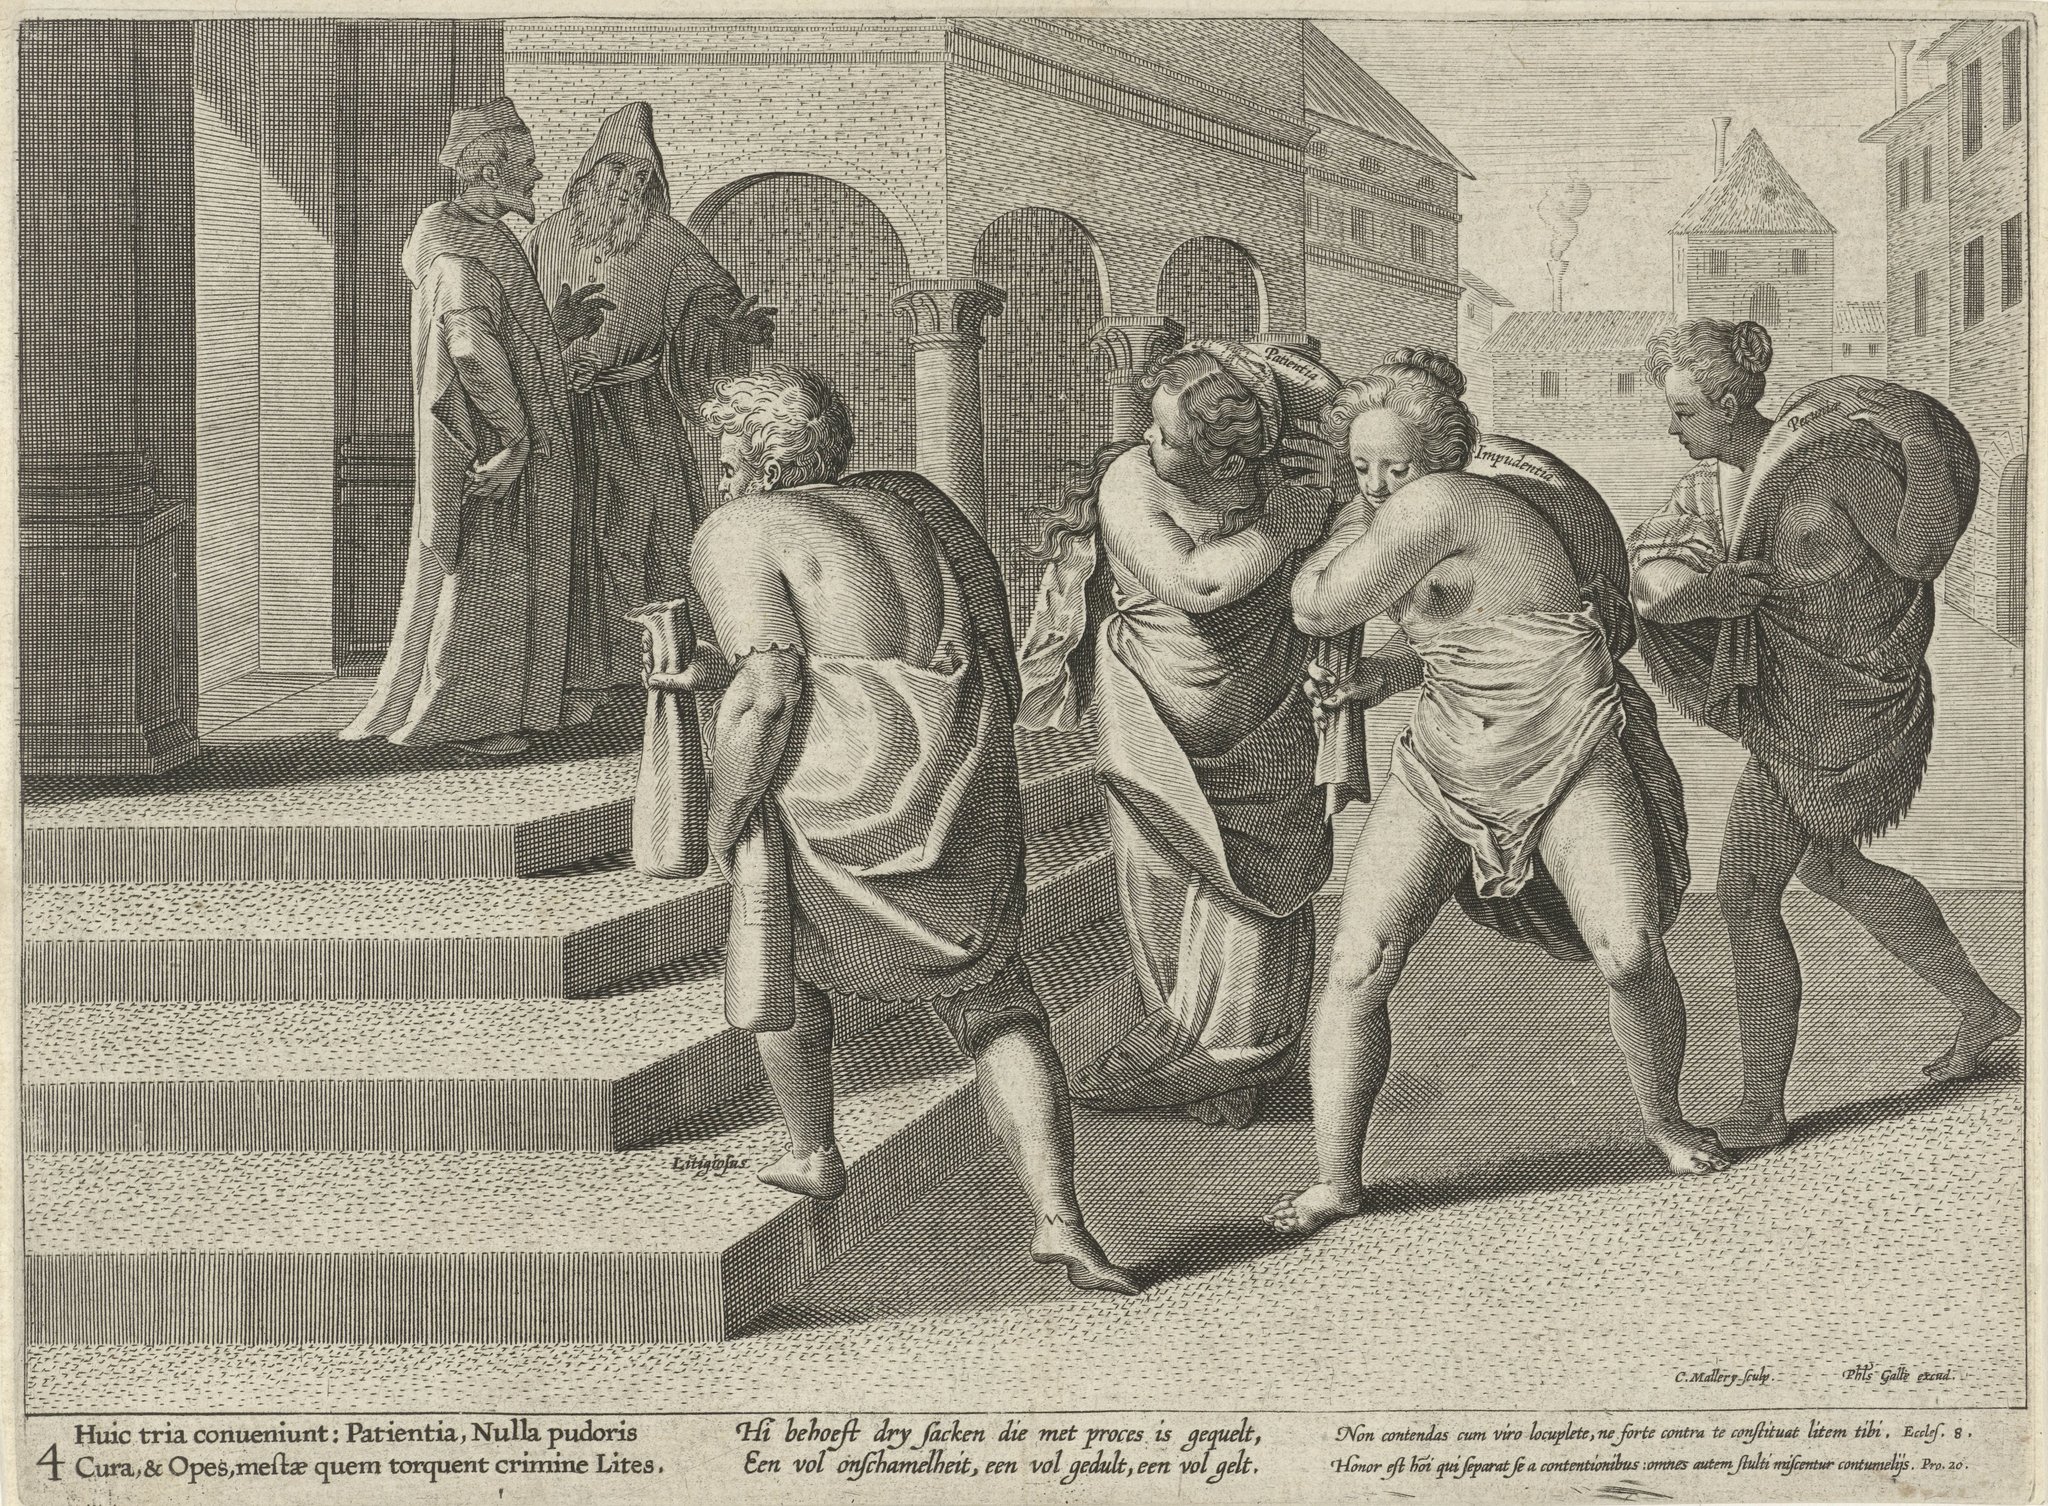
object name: print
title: Litis Abusus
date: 1593-1597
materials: paper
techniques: engraving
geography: antwerp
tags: court building, patience; 'patienza' (ripa), law and jurisprudence (+ judge), 'pecunia' (ripa), litigation, legal proceedings, lawsuit (+ variant), indecency, impudence; 'sfacciatigine' (ripa)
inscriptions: collector's mark: Lugt 240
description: Een aanklager (Litigiosus) loopt de trappen van een gerechtsgebouw op, gevolgd door drie vrouwelijke personificaties die zakken met Geduld (Patientia), Onbeschaamdheid (Impudentia) en Geld (Pecunia) meedragen. Bovenaan twee rechters. De prent heeft drie onderschriften (twee in het Latijn en een in het Nederlands) en maakt deel uit van een achtdelige serie over de misbruiken in procesvoering.